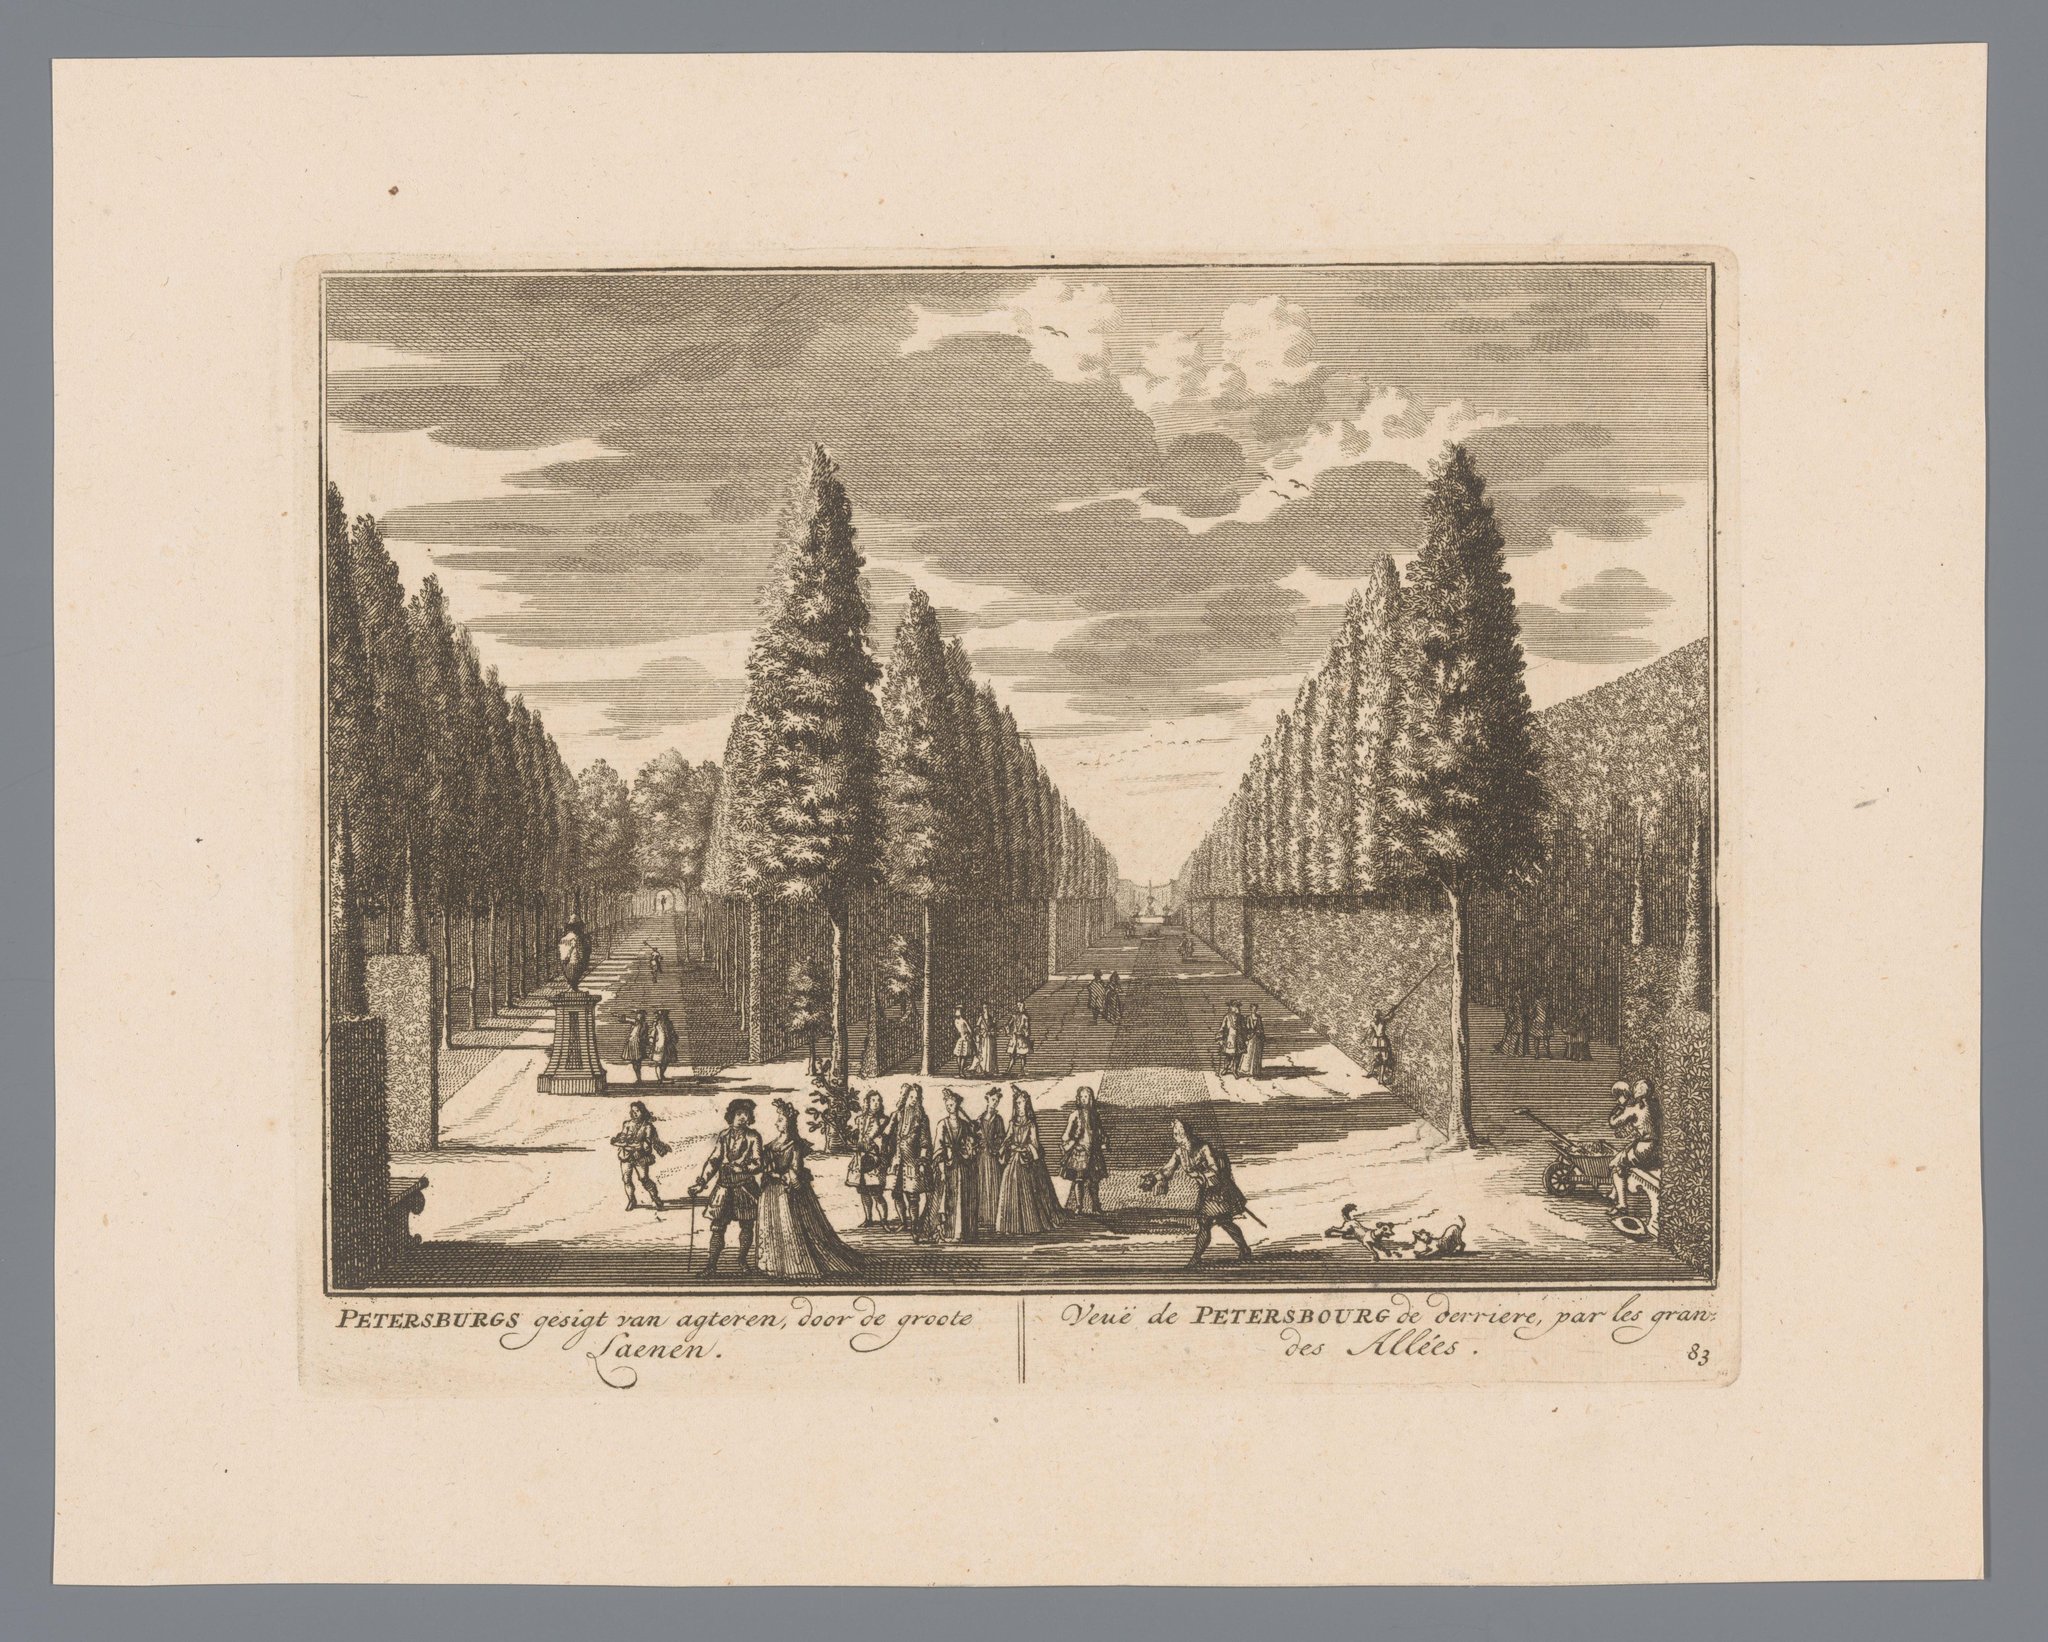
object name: print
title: Gezicht op de lanen van huis Petersburg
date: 1719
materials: paper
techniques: etching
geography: amsterdam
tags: garden fountain, french or architectonic garden; formal garden, lane, alley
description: Prent uit: De zegepraalende Vecht, vertoonende verscheidene gesichten van lustplaatsen, heeren huysen en dorpen, beginnende van Uitrecht en met Muyden besluytende. Amsterdam: Wed. Nicolaes Visscher, 1719.